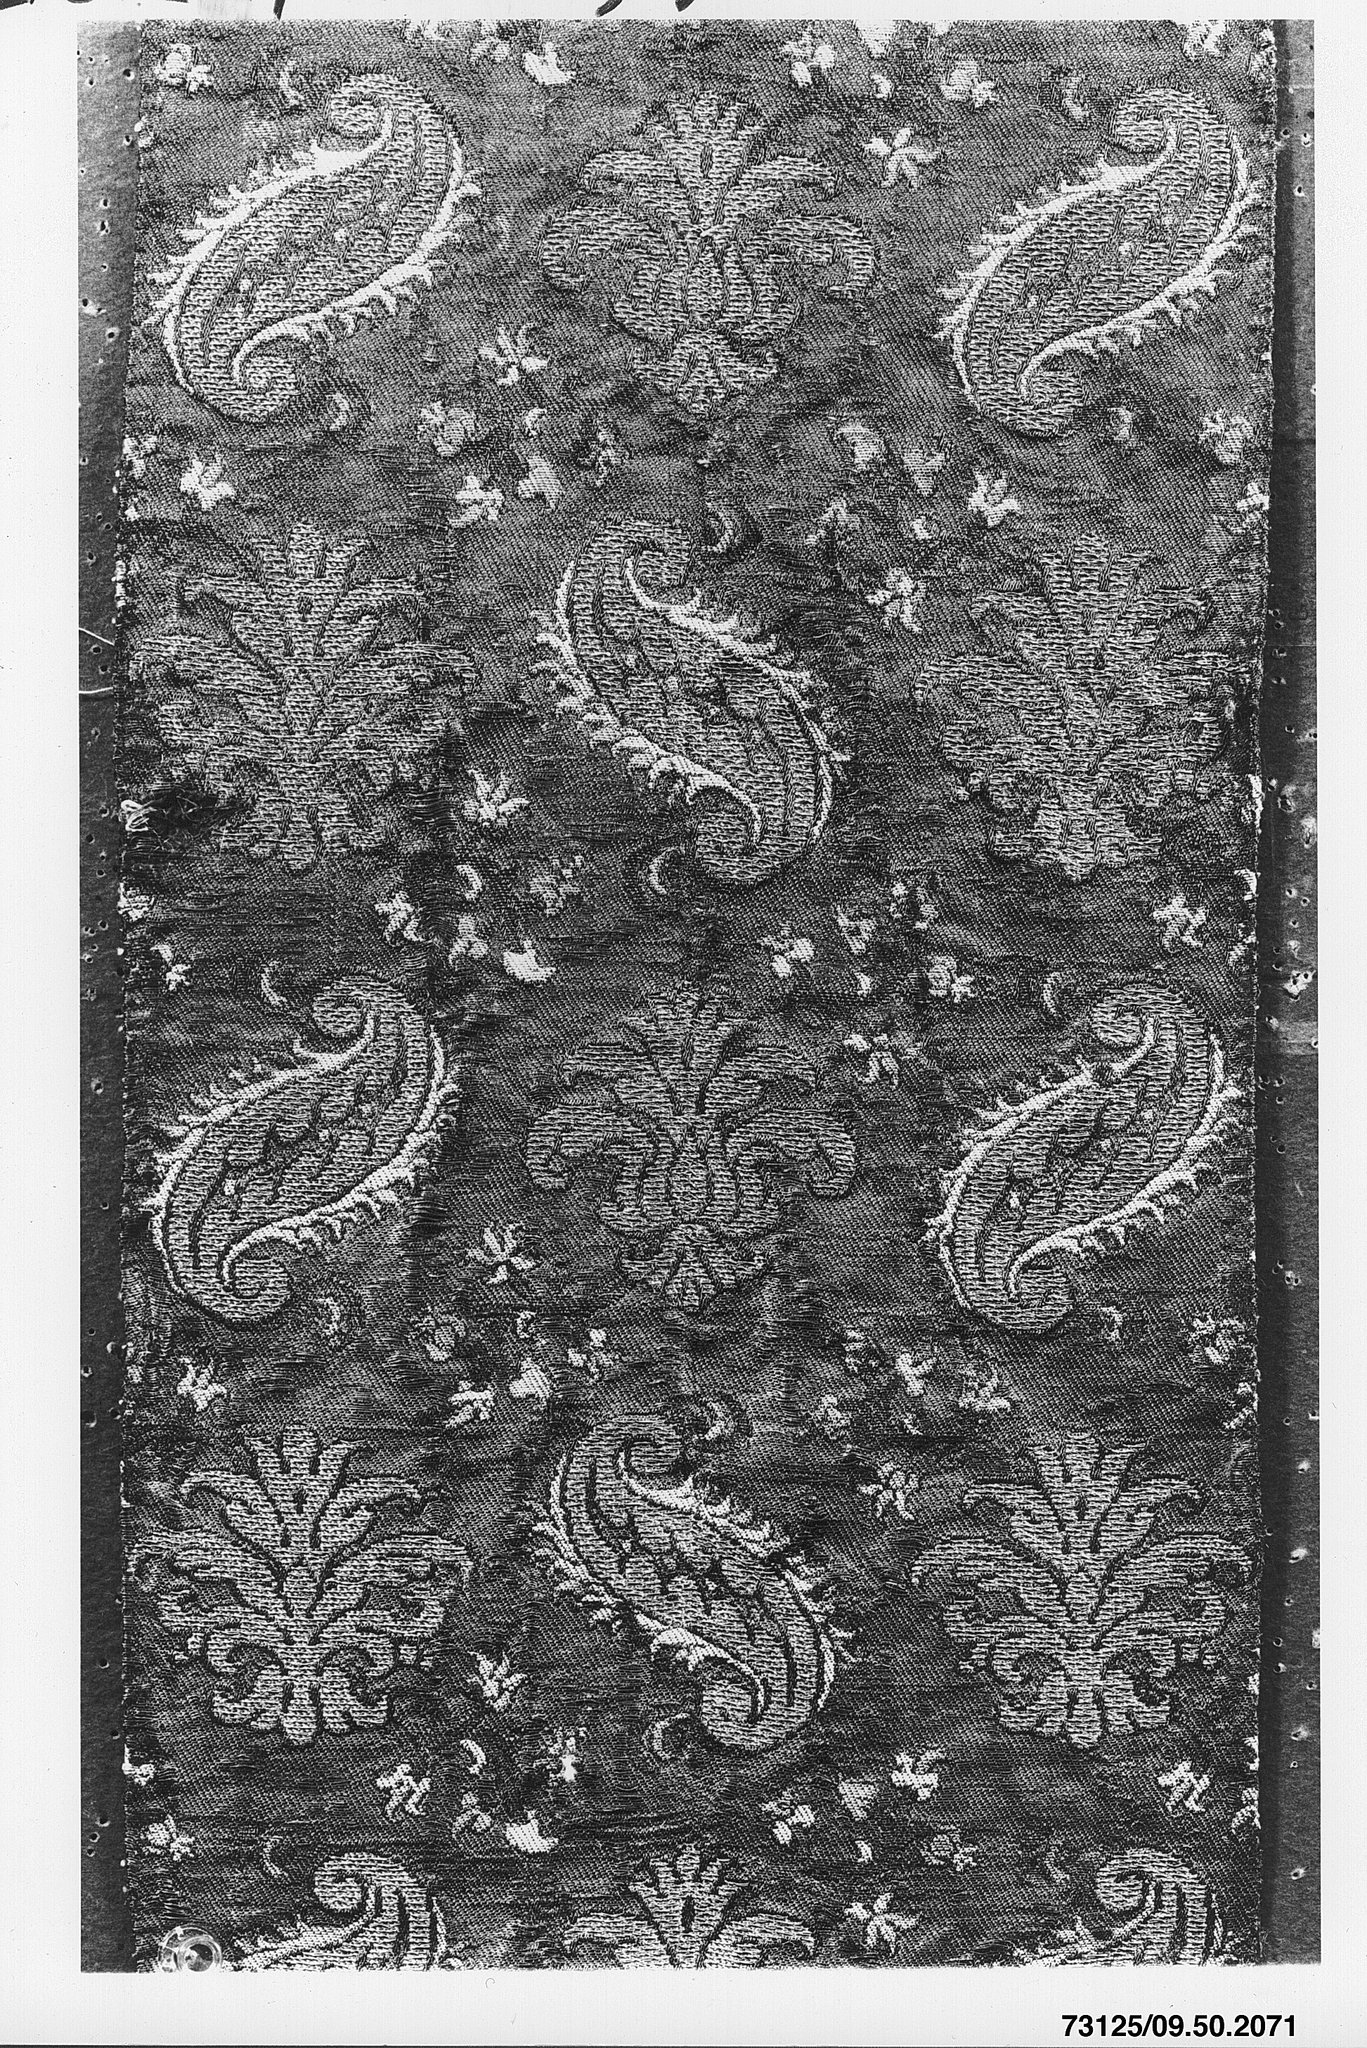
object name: piece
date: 1701-1800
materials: metal thread, silk